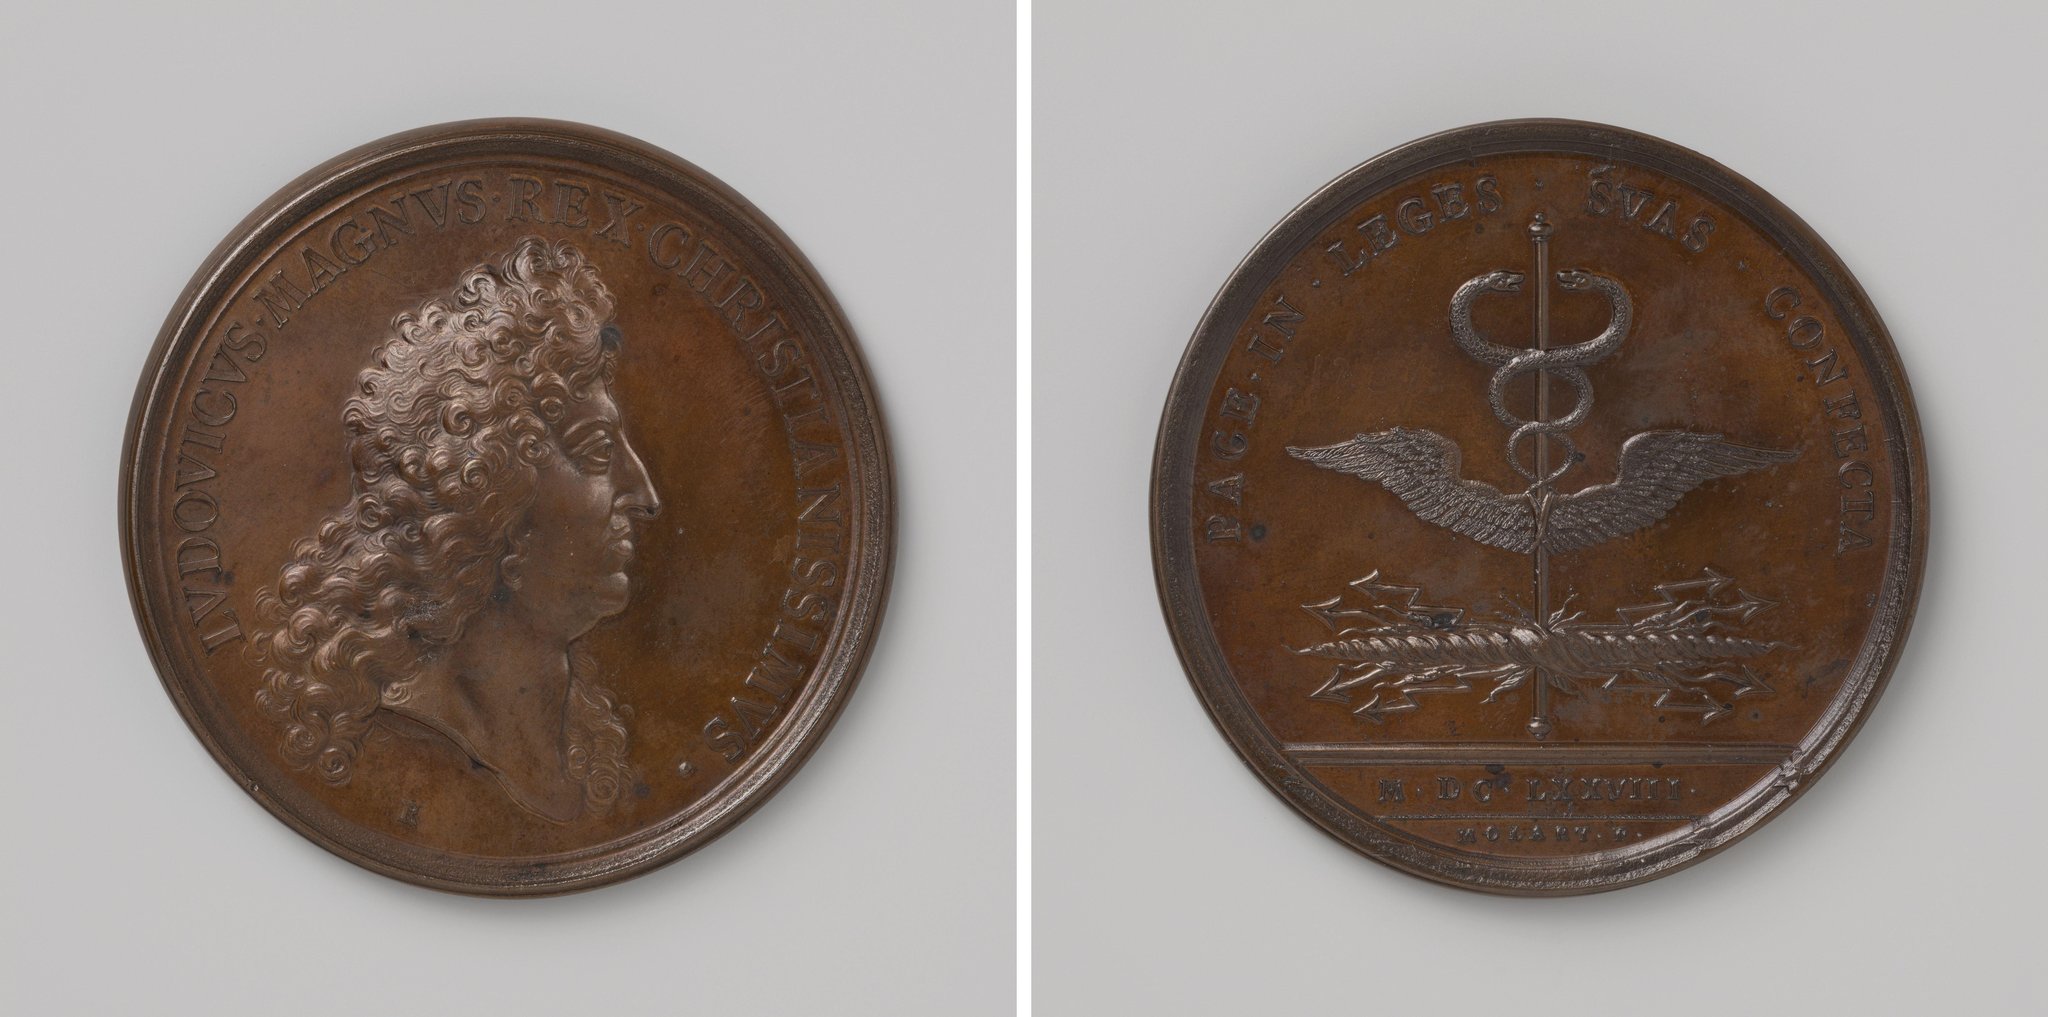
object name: history medal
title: Vrede van Nijmegen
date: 1678-1700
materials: bronze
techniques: striking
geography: paris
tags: lodewijk xiv (koning van frankrijk), nijmegen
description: Bronzen penning. Voorzijde: borststuk man binnen omschrift. Keerzijde: gevleugelde Mercuriusstaf en bliksemschichten binnen omschrift; afsnede: jaartal.